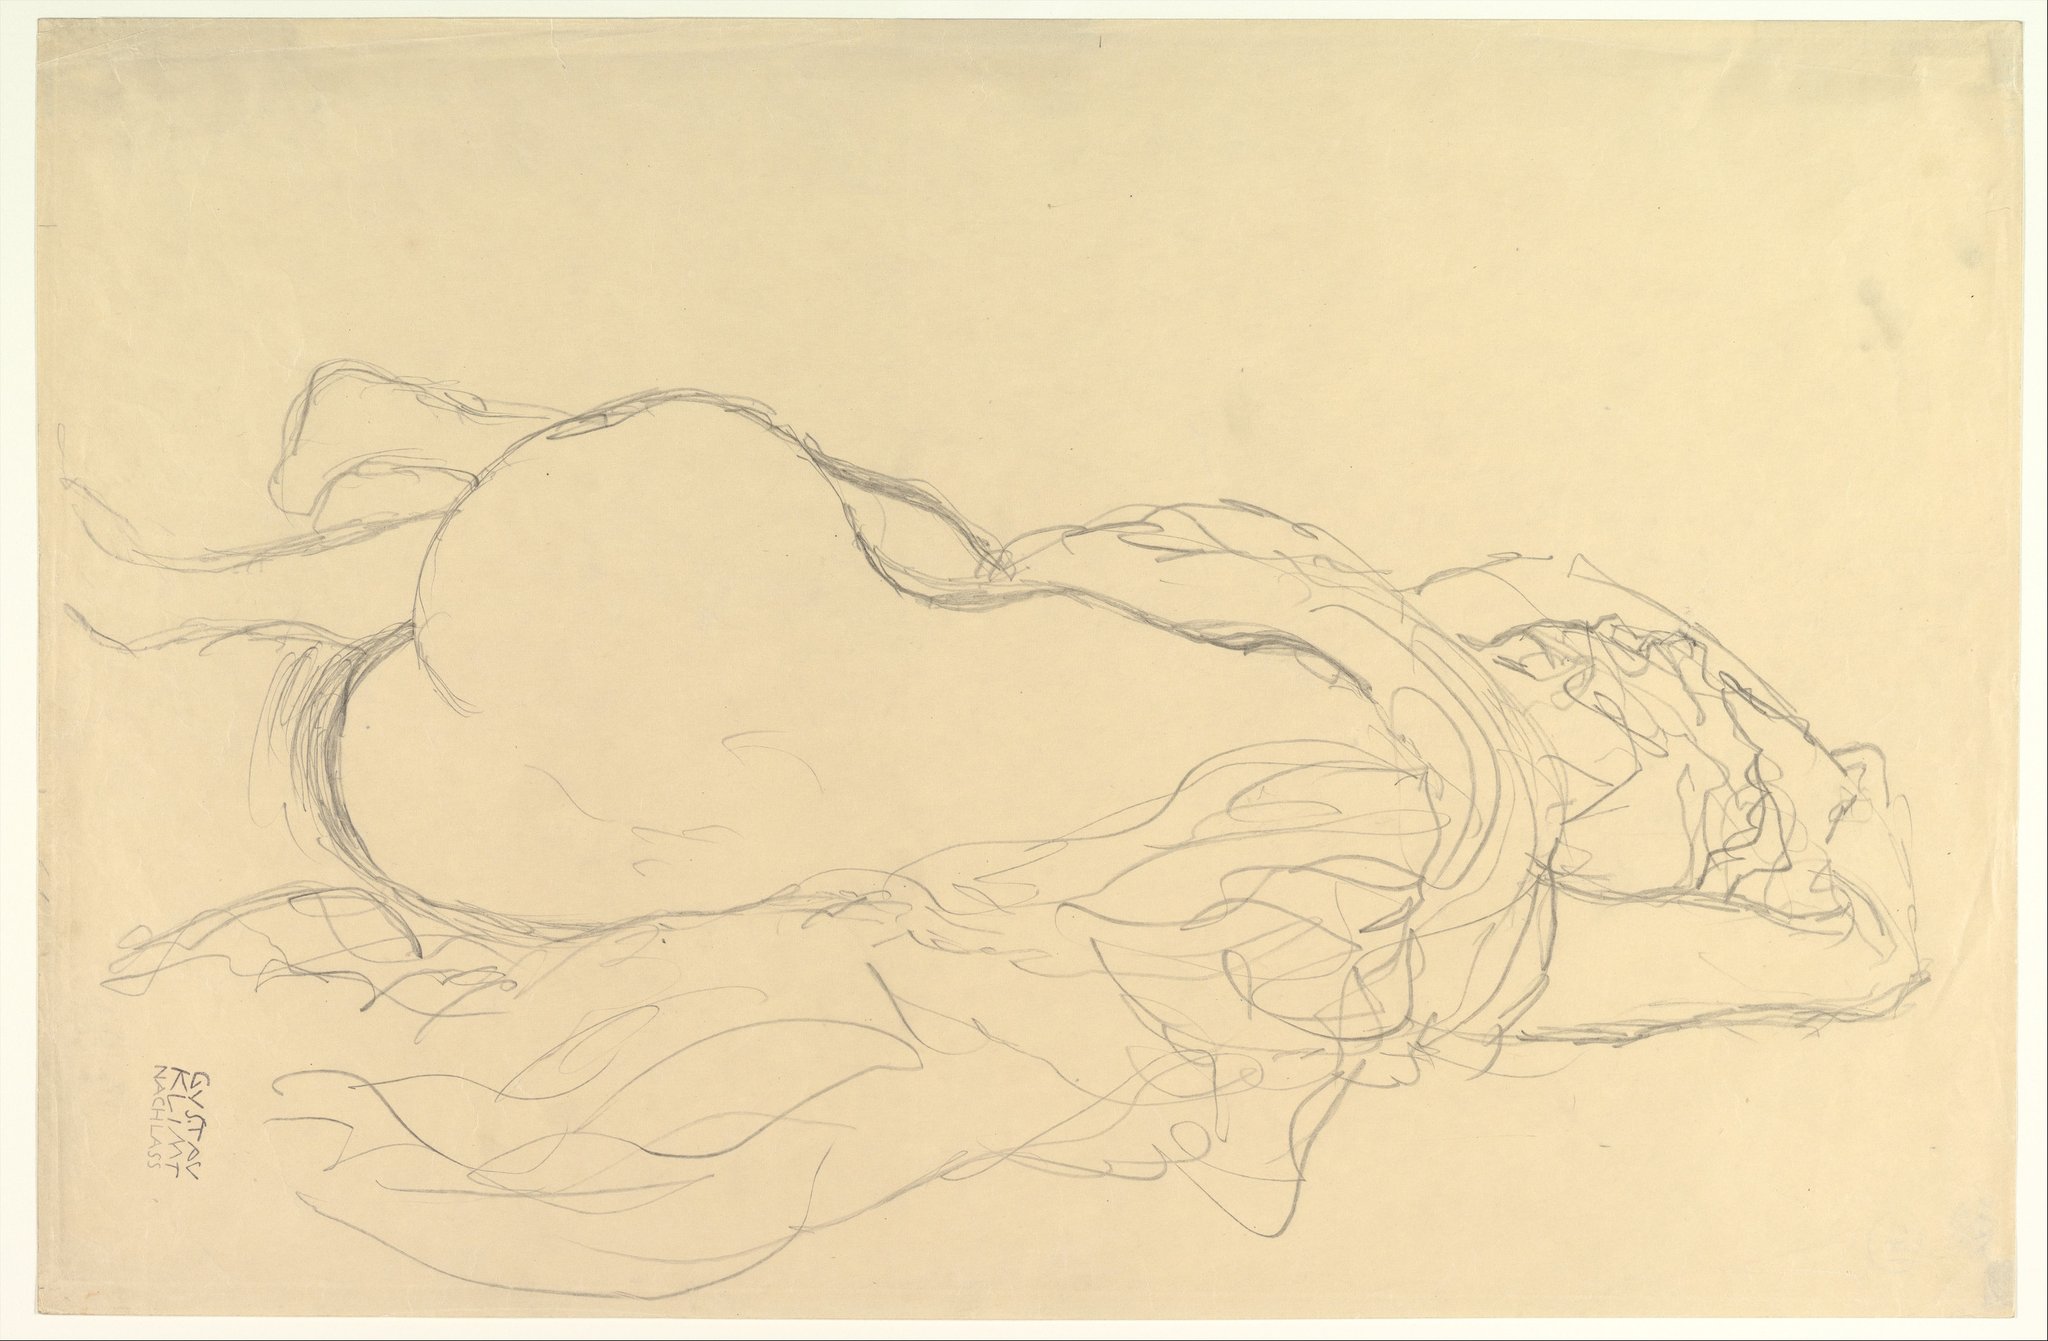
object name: drawing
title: Reclining Nude with Drapery, Back View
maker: gustav klimt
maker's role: artist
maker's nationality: austrian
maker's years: 1862-1918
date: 1917-1918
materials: graphite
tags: female nudes